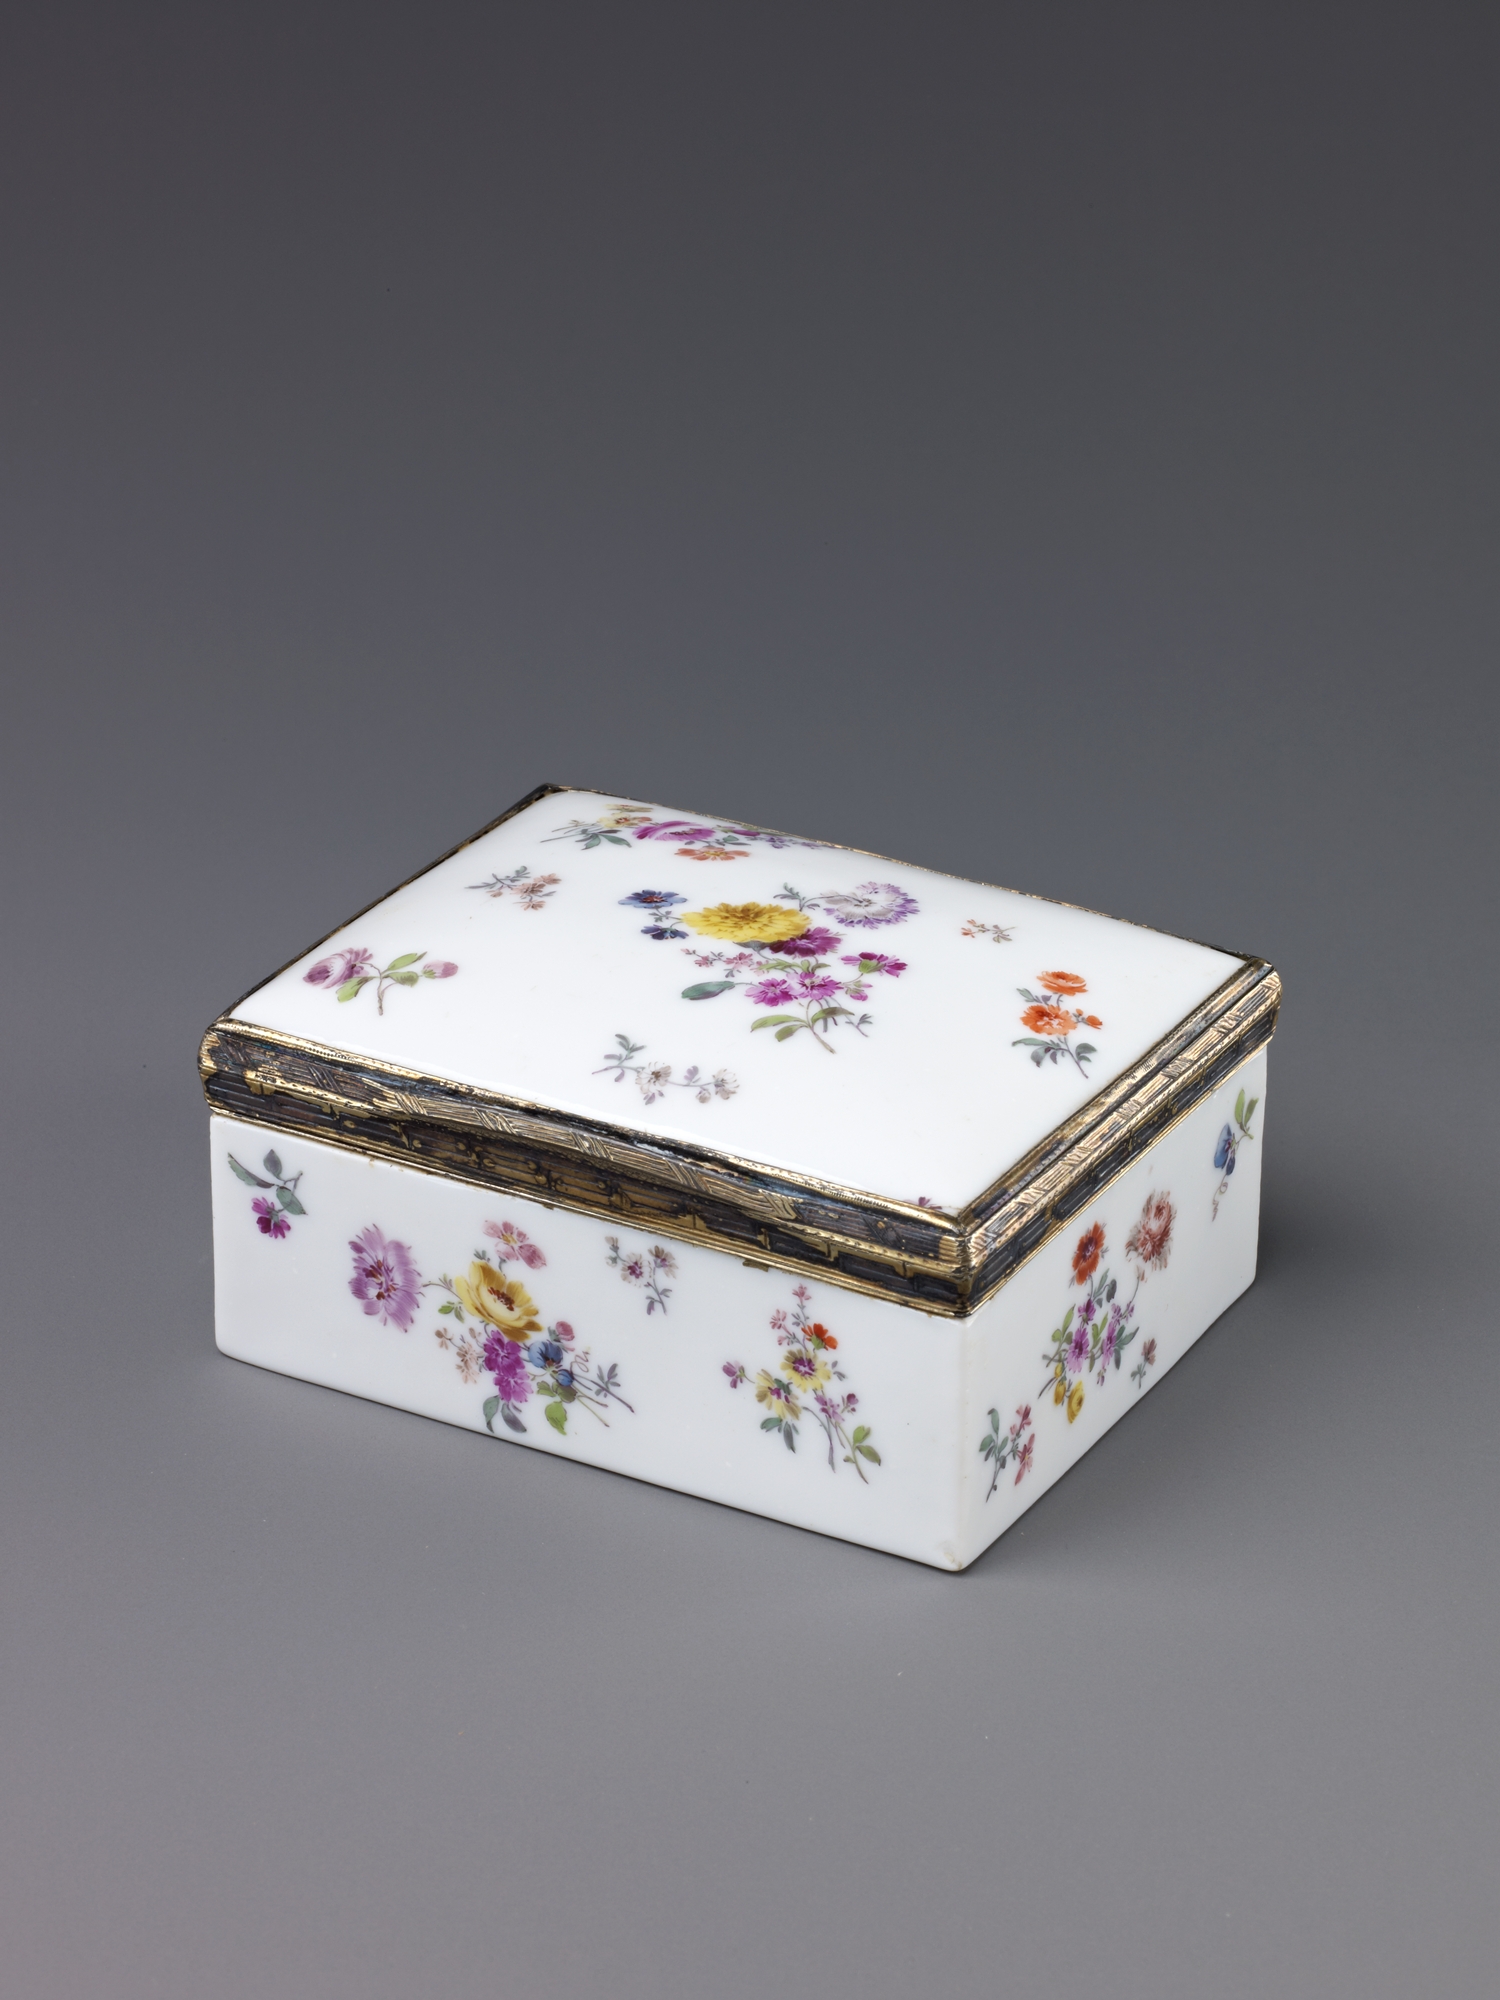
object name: snuffbox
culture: german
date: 1760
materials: hard paste porcelain, silver gilt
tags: flowers